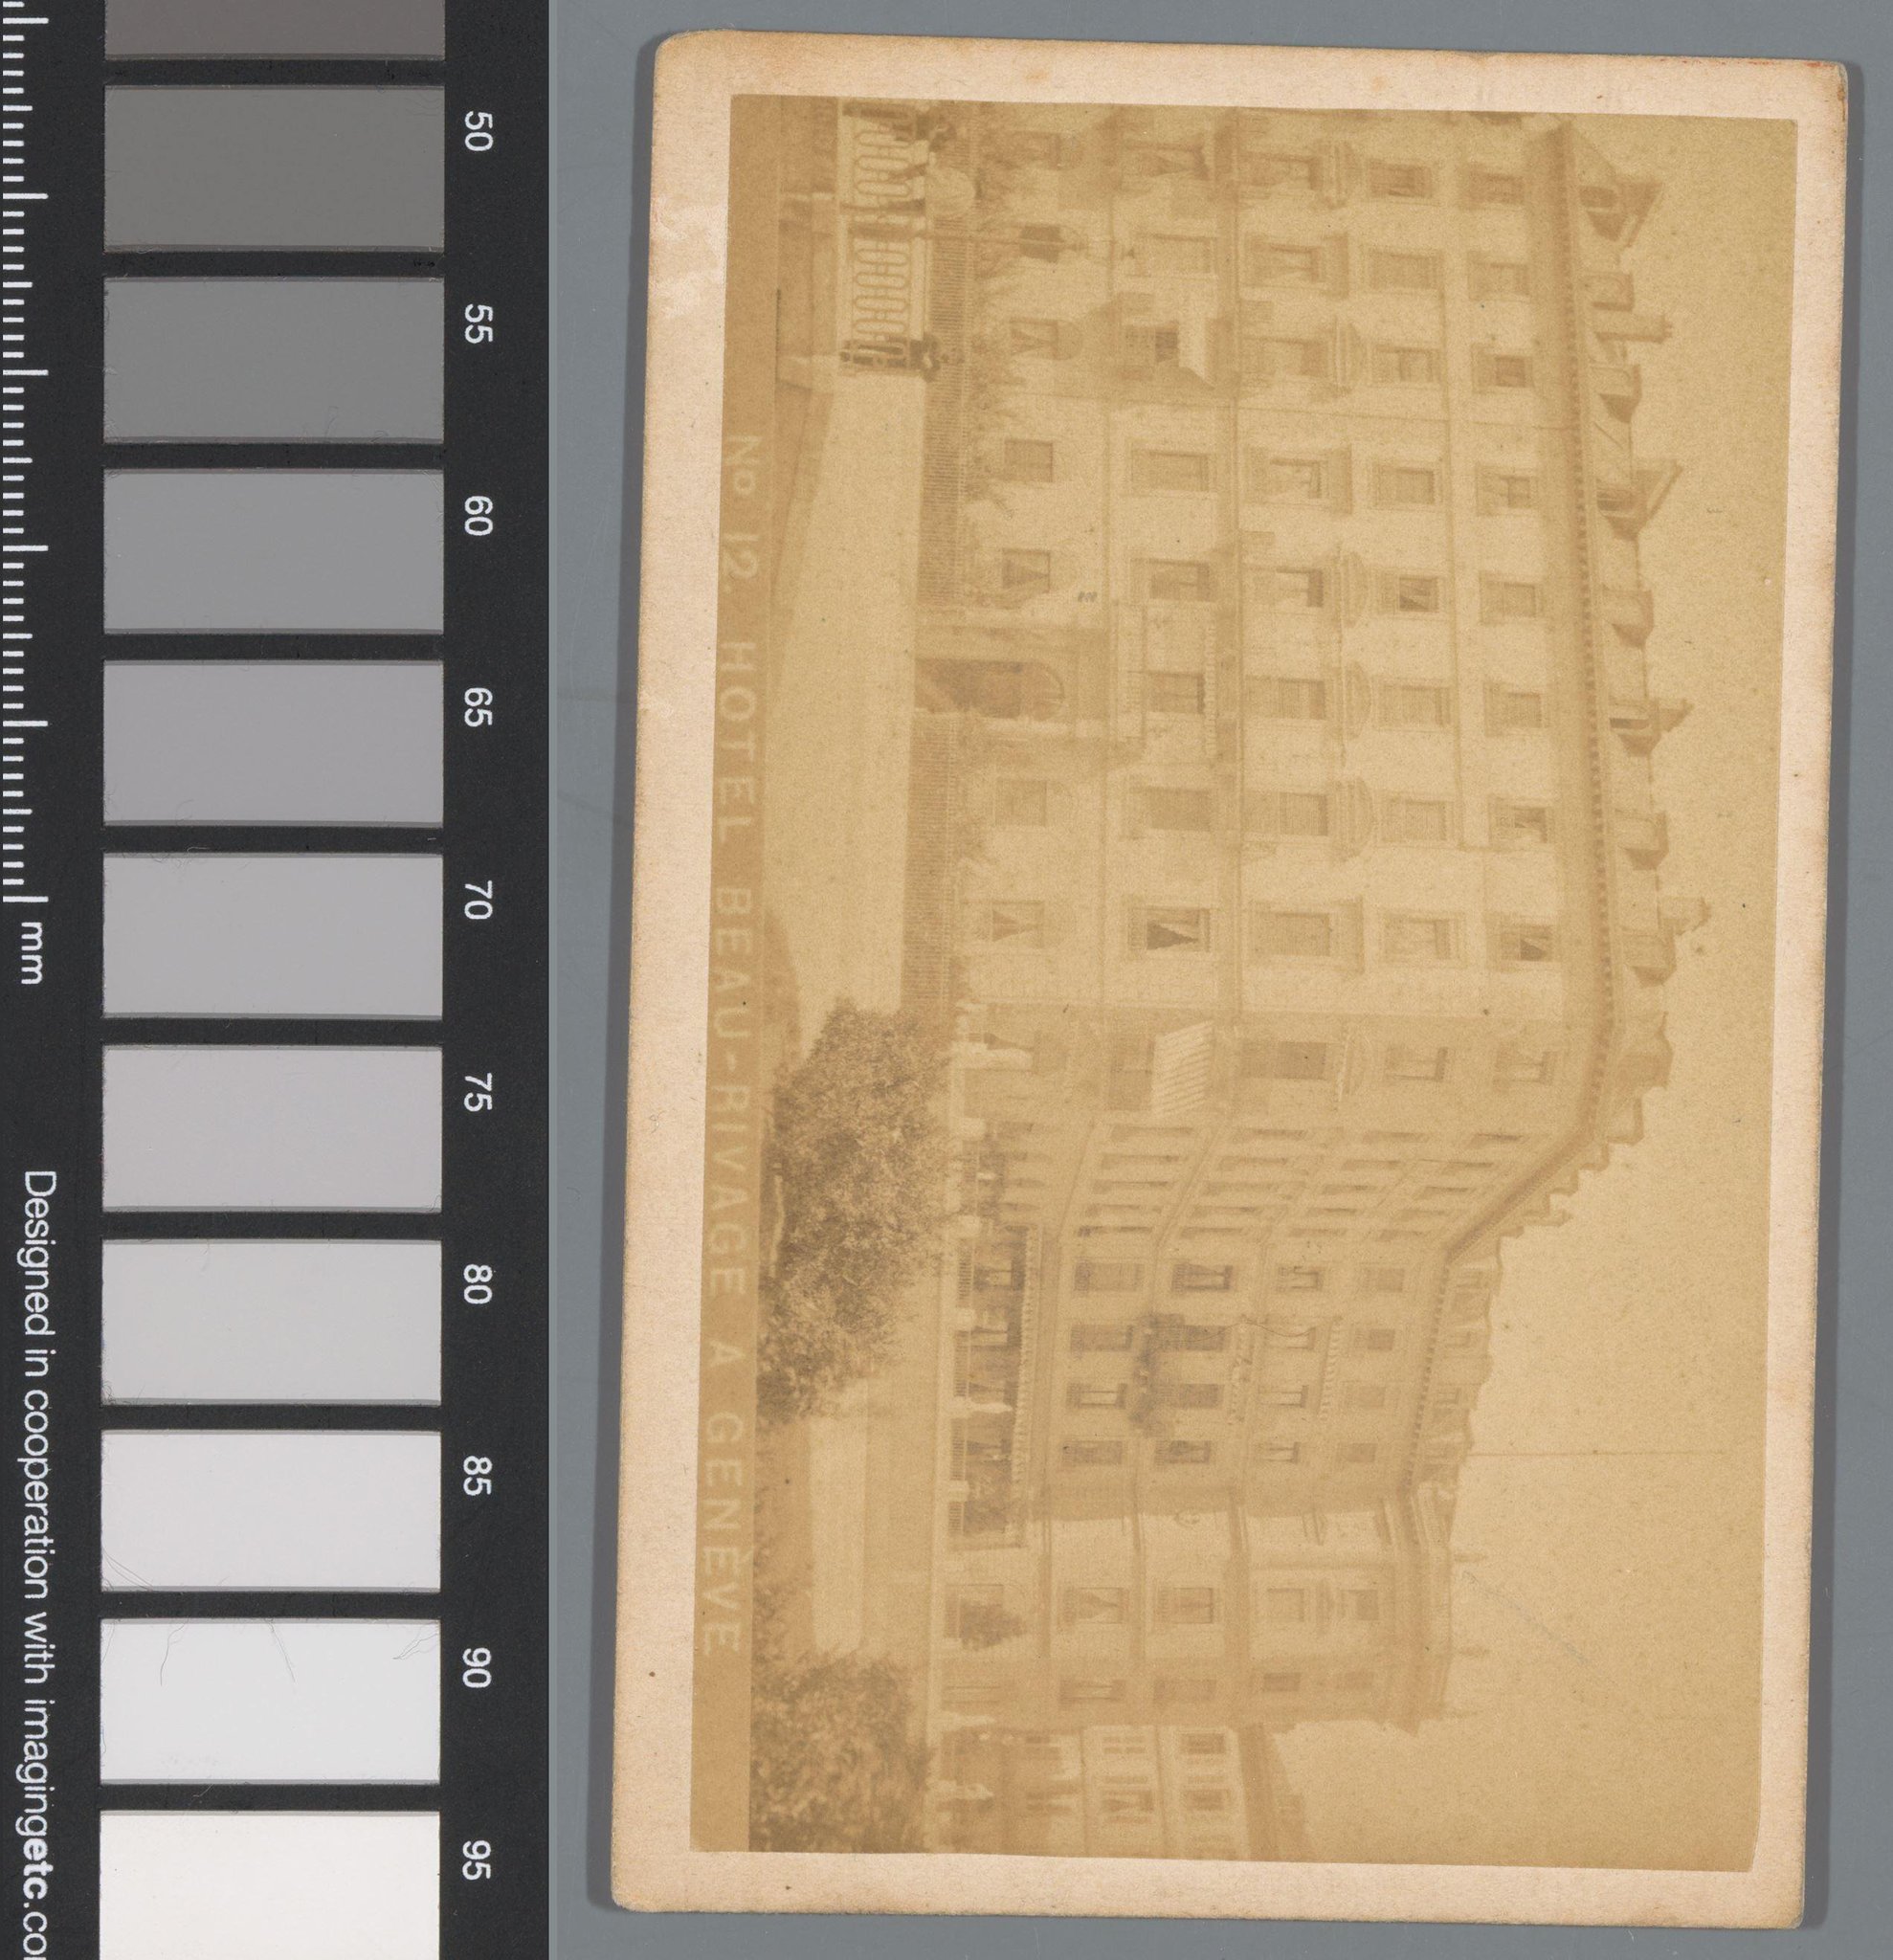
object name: photograph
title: Hotel Beau-Rivage in Genève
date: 1855-1885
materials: cardboard, paper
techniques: albumen print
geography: geneva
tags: hotel, hostelry, inn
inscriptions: inscription: ‘Vues panoramiques/ Th. Boulanger & Cie/ Photographes-Éditeurs/ 12, Place Longemalle, 12/ Genève/ Toute Reproduction est Interdite/ Déposé. Déposé.’, inscription: ‘No 12.’